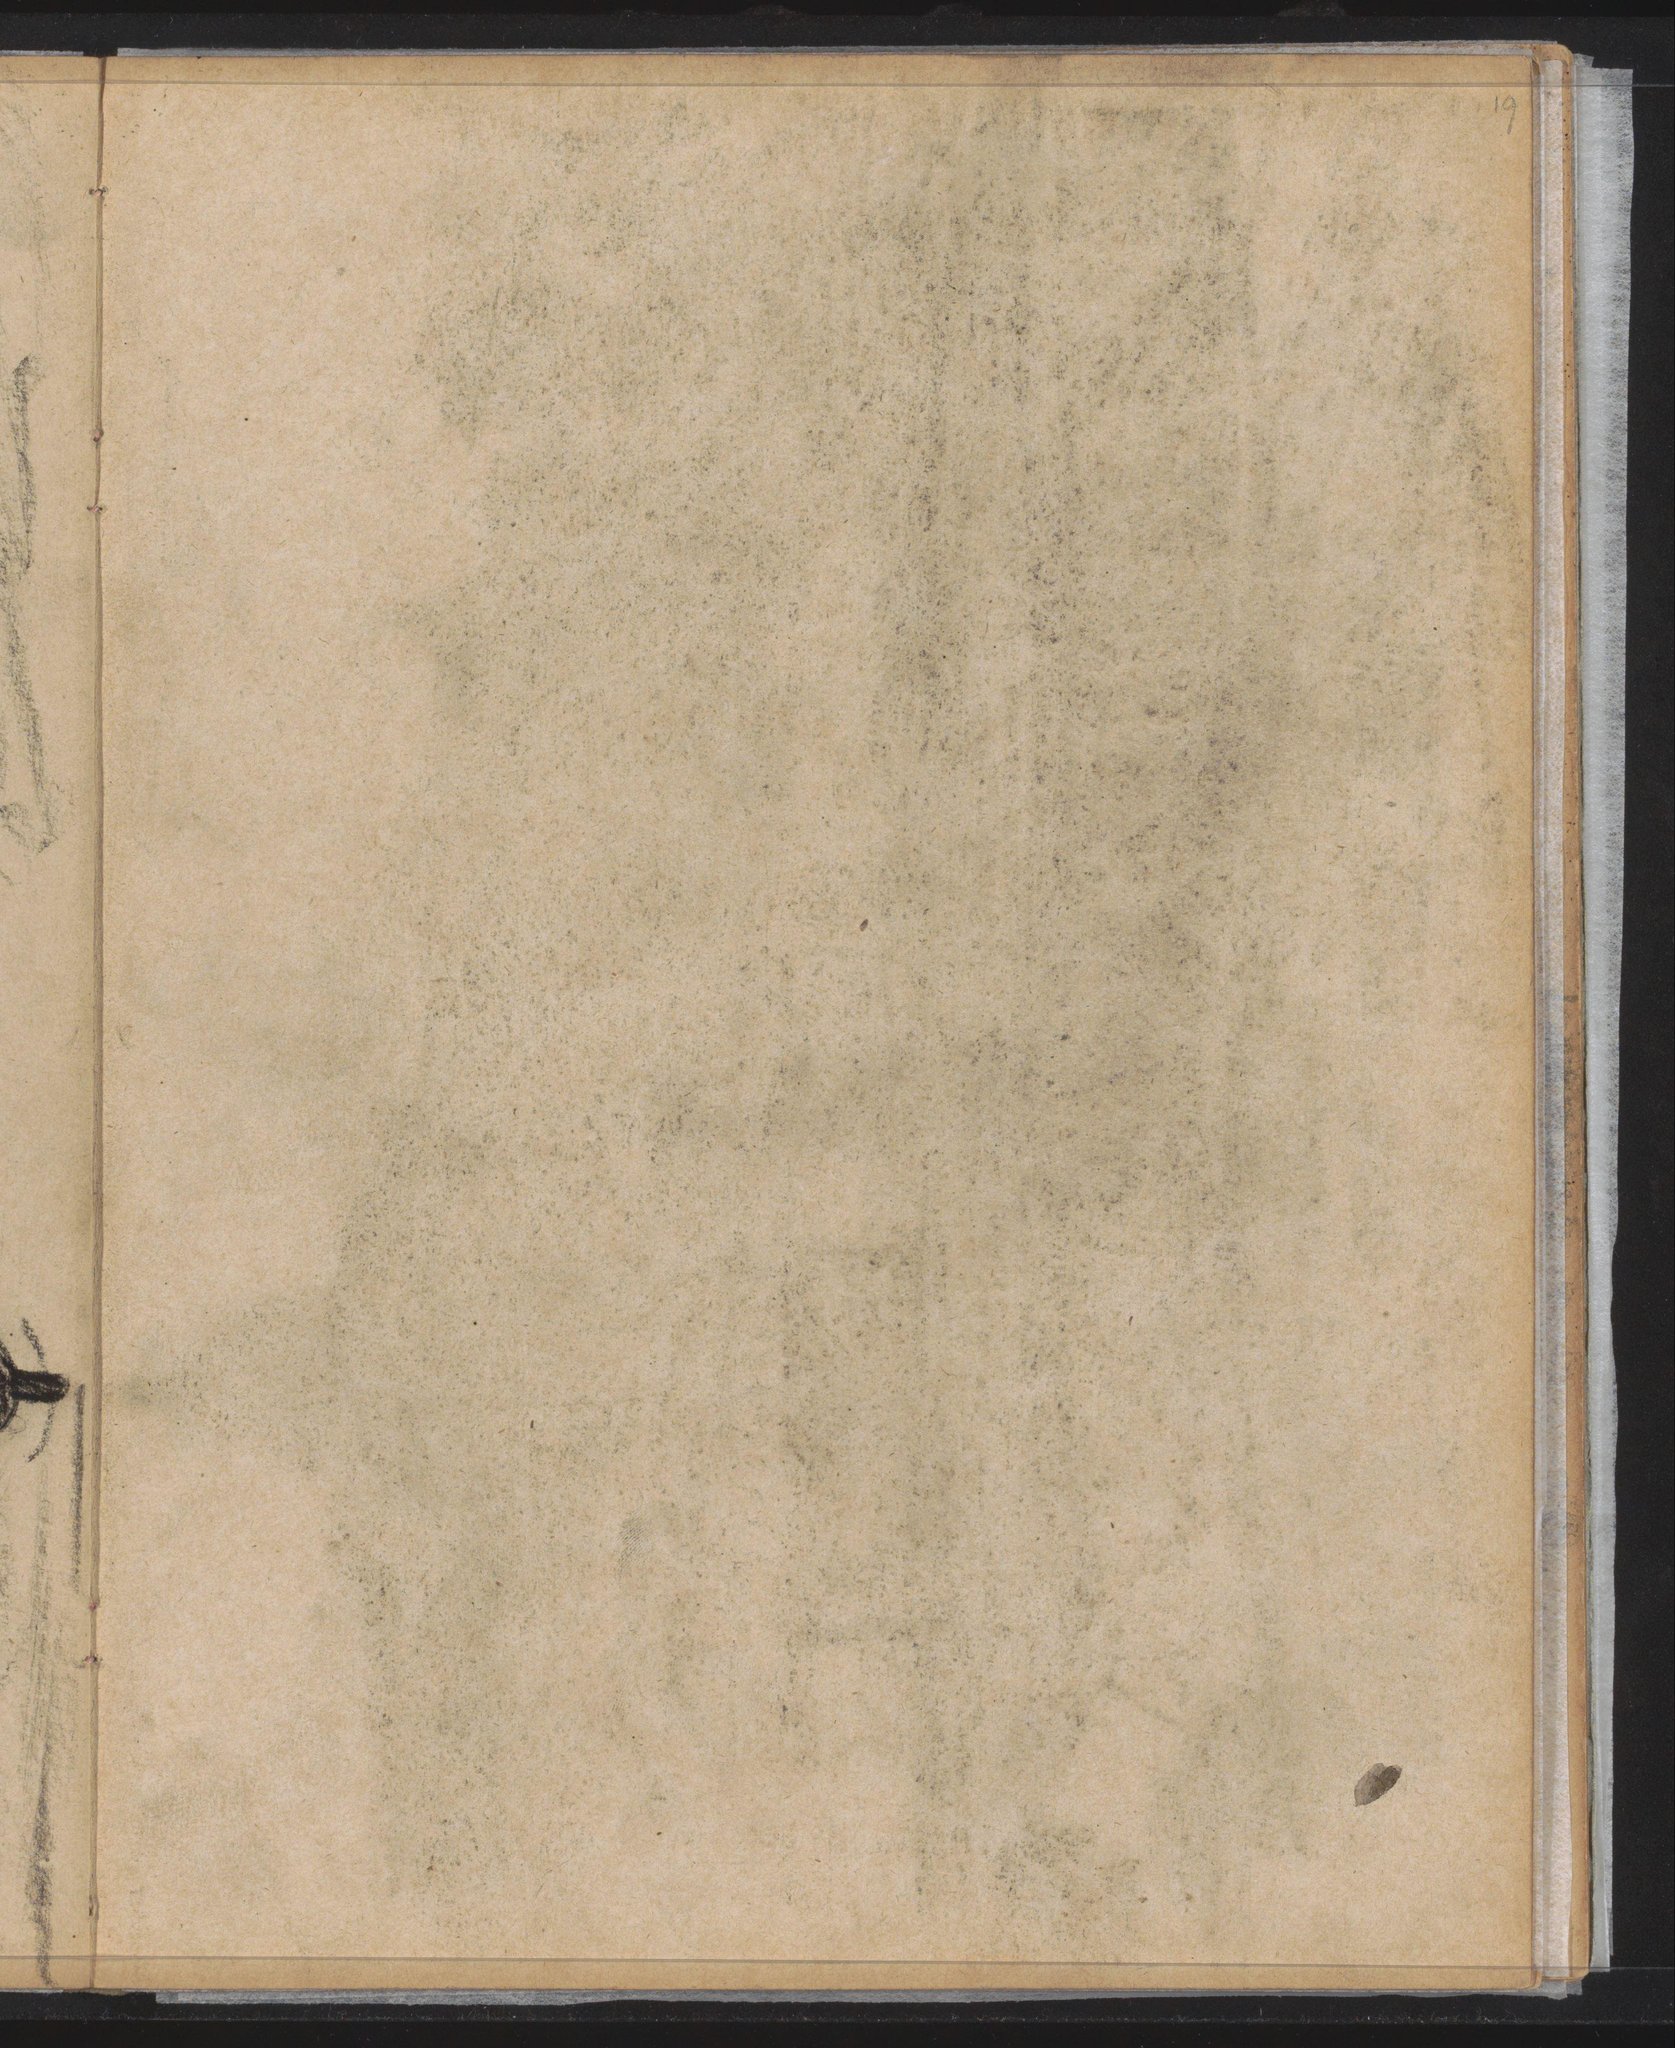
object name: sketchbook leaf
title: Abklatsch van de krijttekening op pagina 18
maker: willem witsen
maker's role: draughtsman, painter, print maker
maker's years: 1860-1923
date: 1884-1891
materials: paper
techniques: printmaking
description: Pagina 19 uit een schetsboek met 49 bladen.